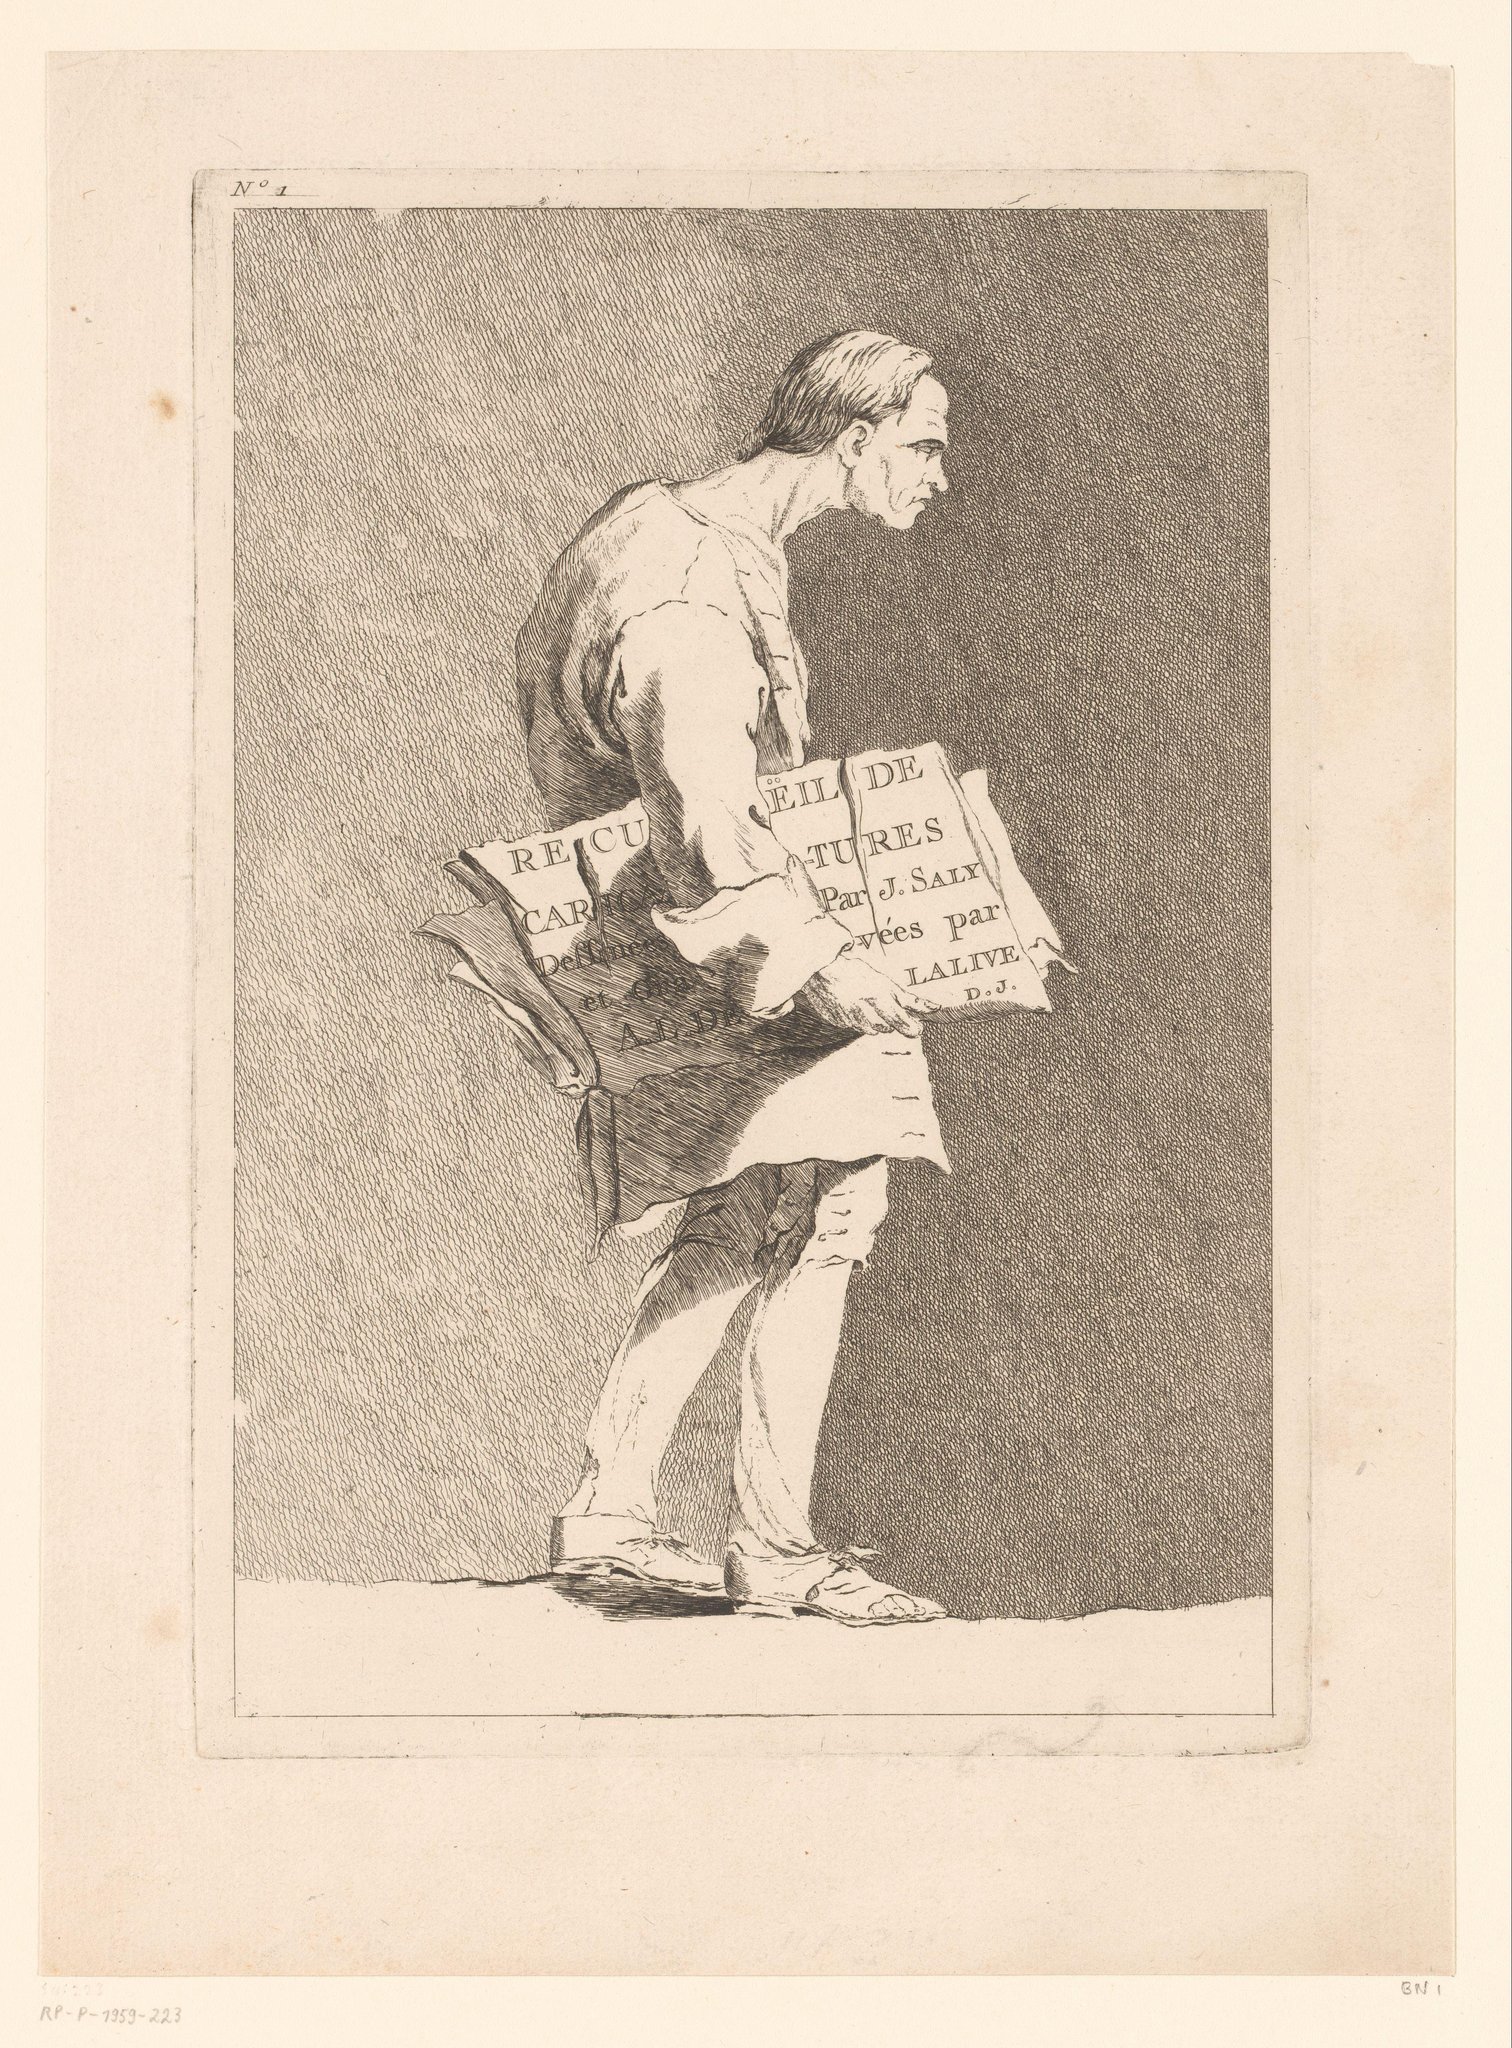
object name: print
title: Recueil de caricatures dessinées Par J. Saly et Gravées par A.L. De Lalive D.J.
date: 1745-1779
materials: paper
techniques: etching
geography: france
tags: caricatures (human types), hunchback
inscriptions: collector's mark: Lugt 2228, collector's mark: Lugt 2760